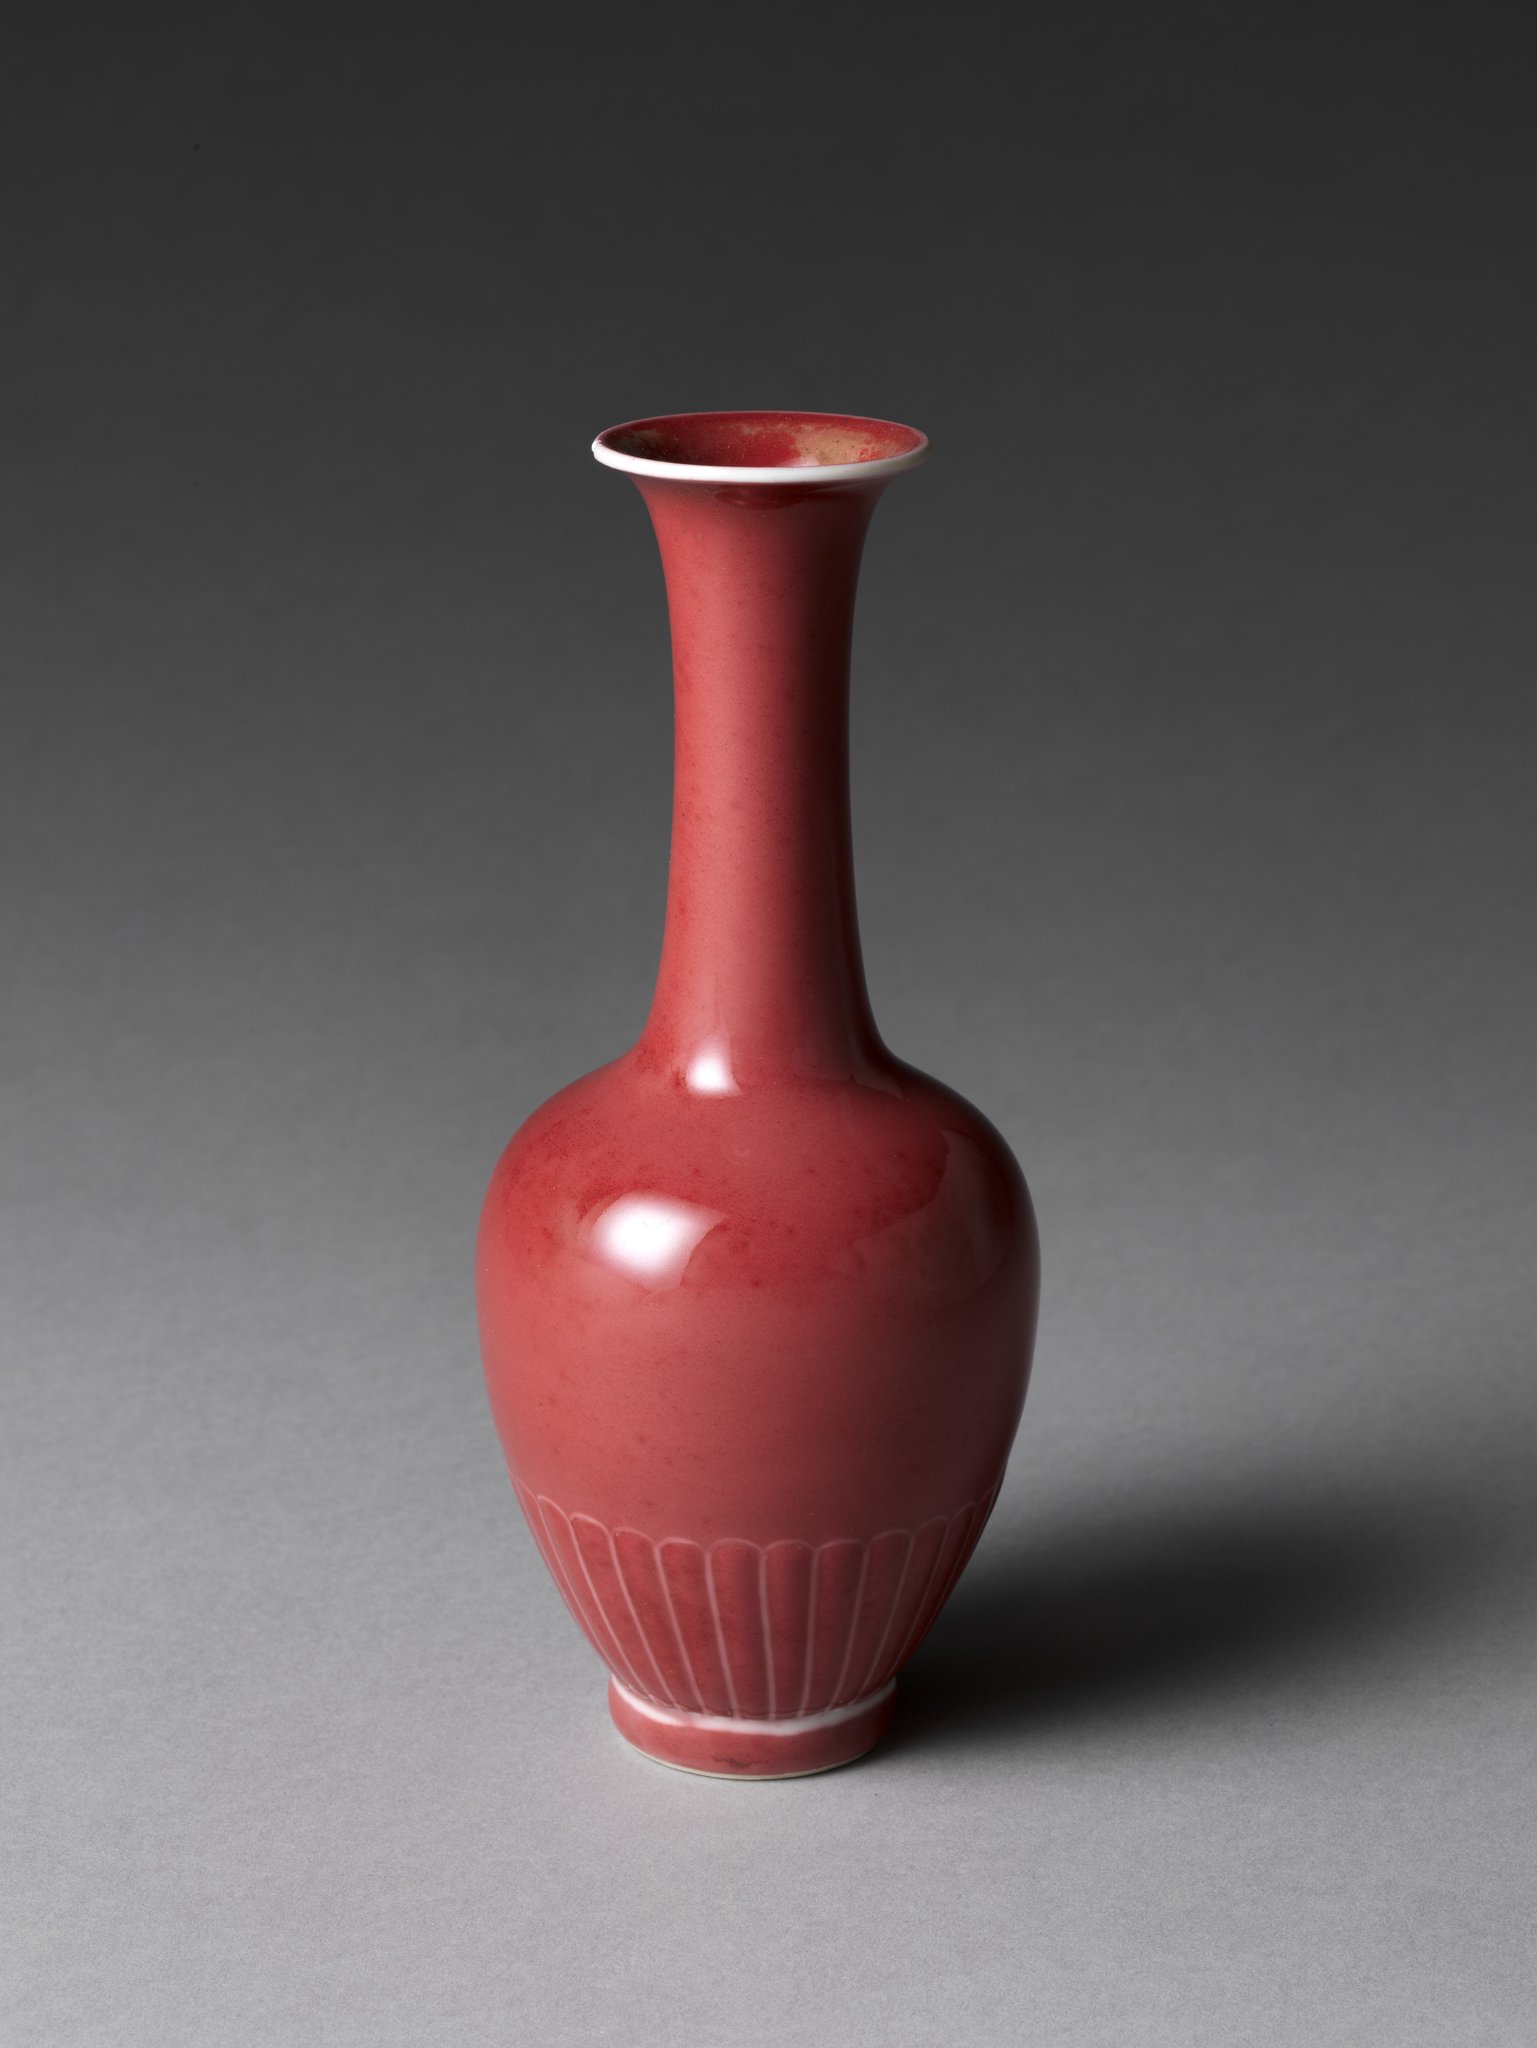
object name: vase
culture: chinese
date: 1678-1688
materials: glaze, porcelain